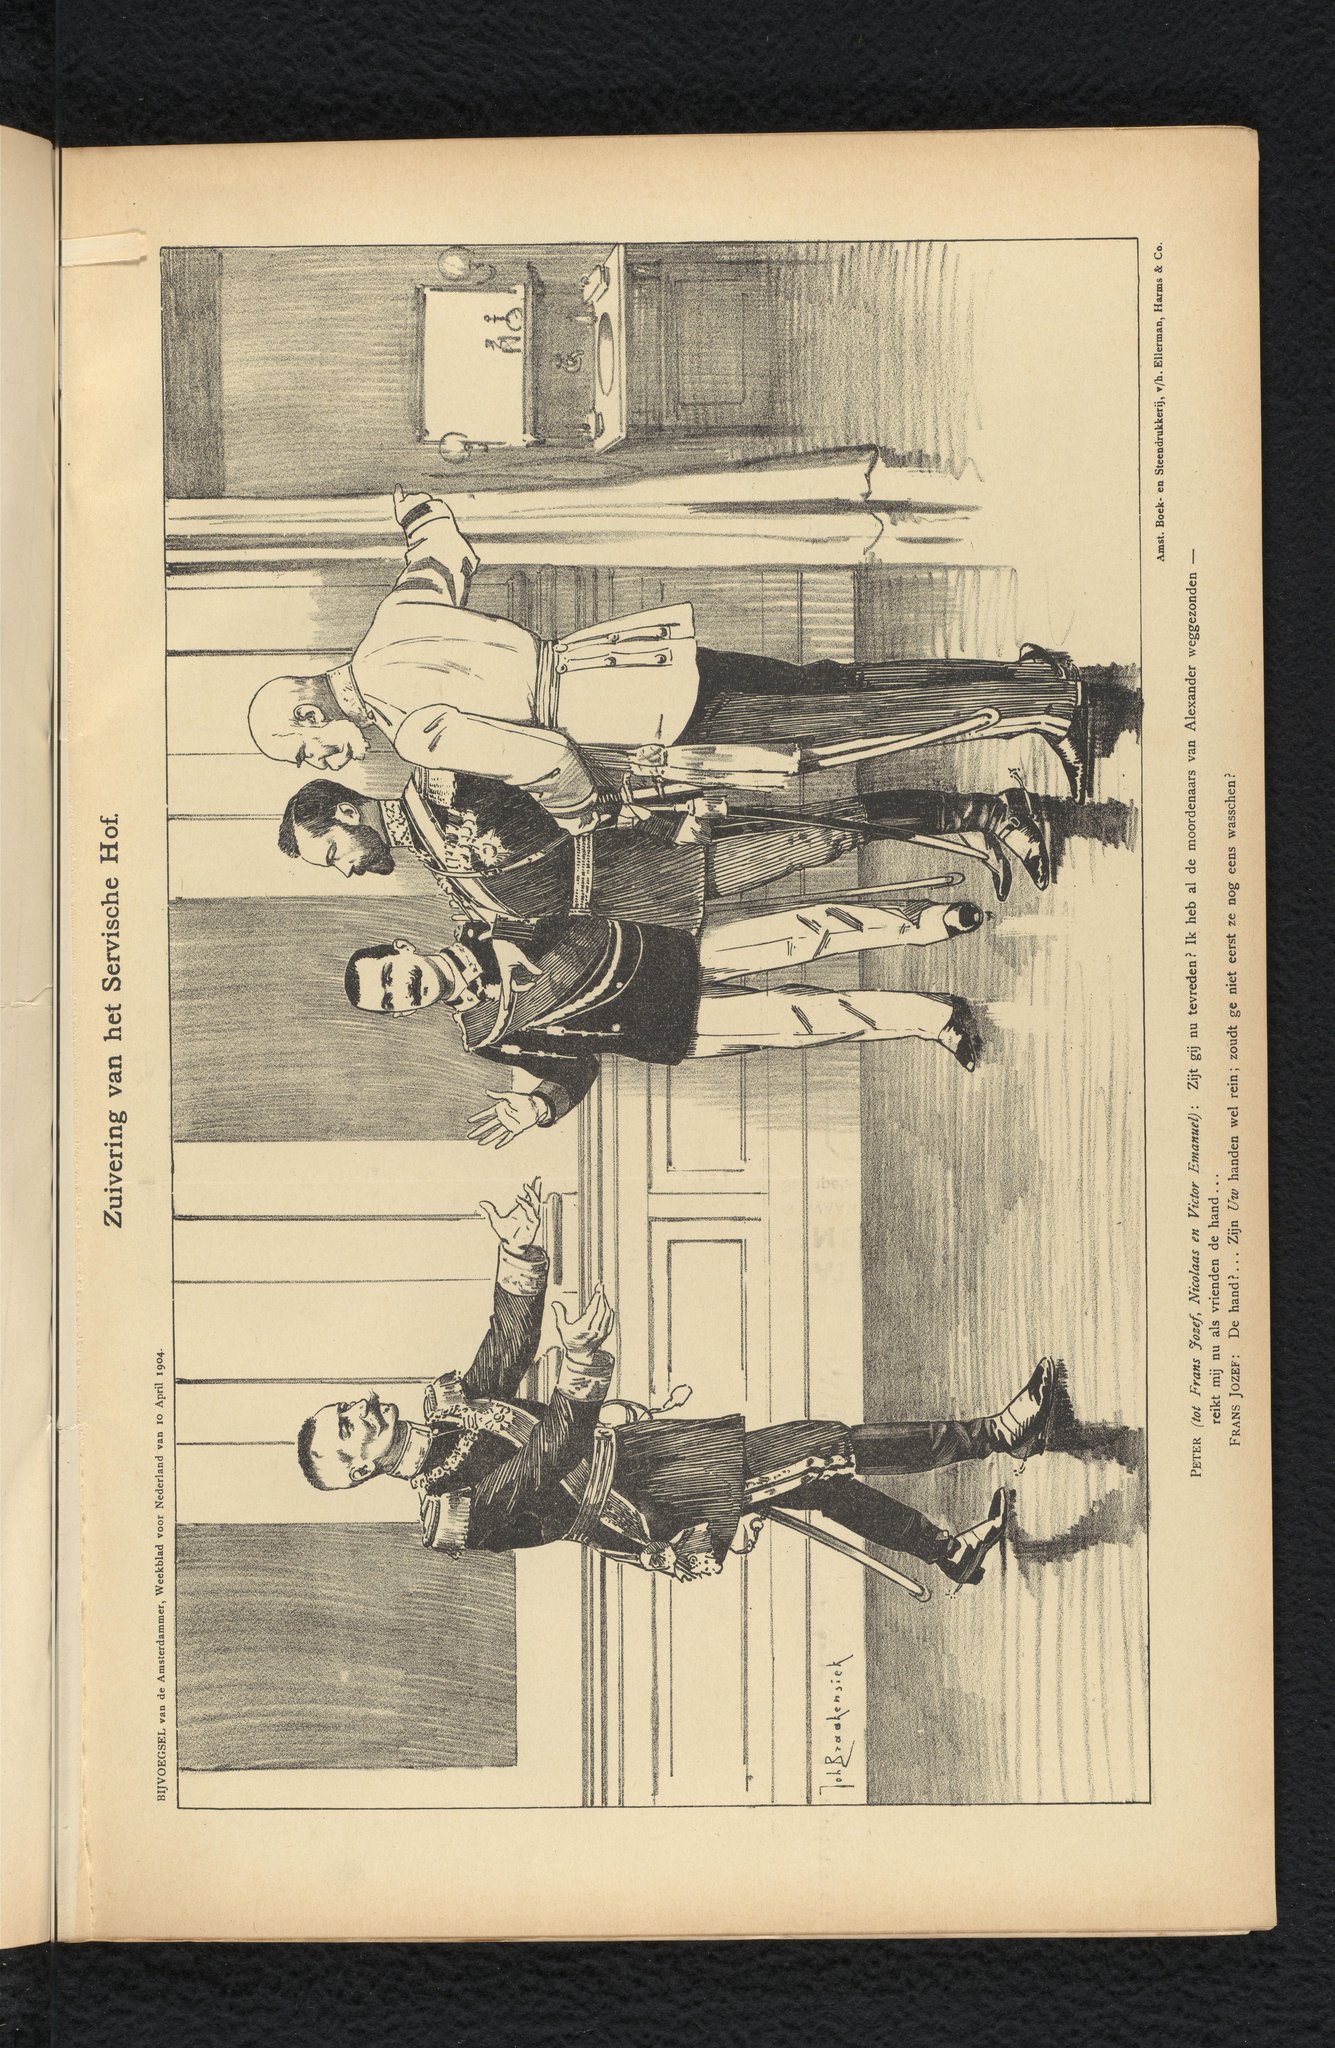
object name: cartoon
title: Zuivering van het Servische Hof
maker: johan braakensiek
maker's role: draughtsman, print maker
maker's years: 1858-1940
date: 1904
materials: paper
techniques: lithograph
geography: netherlands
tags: vienna, washing one's hands, political caricatures and satires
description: Peter I, koning van Servië, zoekt na de moord op zijn voorganger Alexander I, aansluiting bij tsaar Nicolaas II, keizer Frans Jozef en koning Victor Emmanuel III. Hij moet eerst zijn handen wassen.